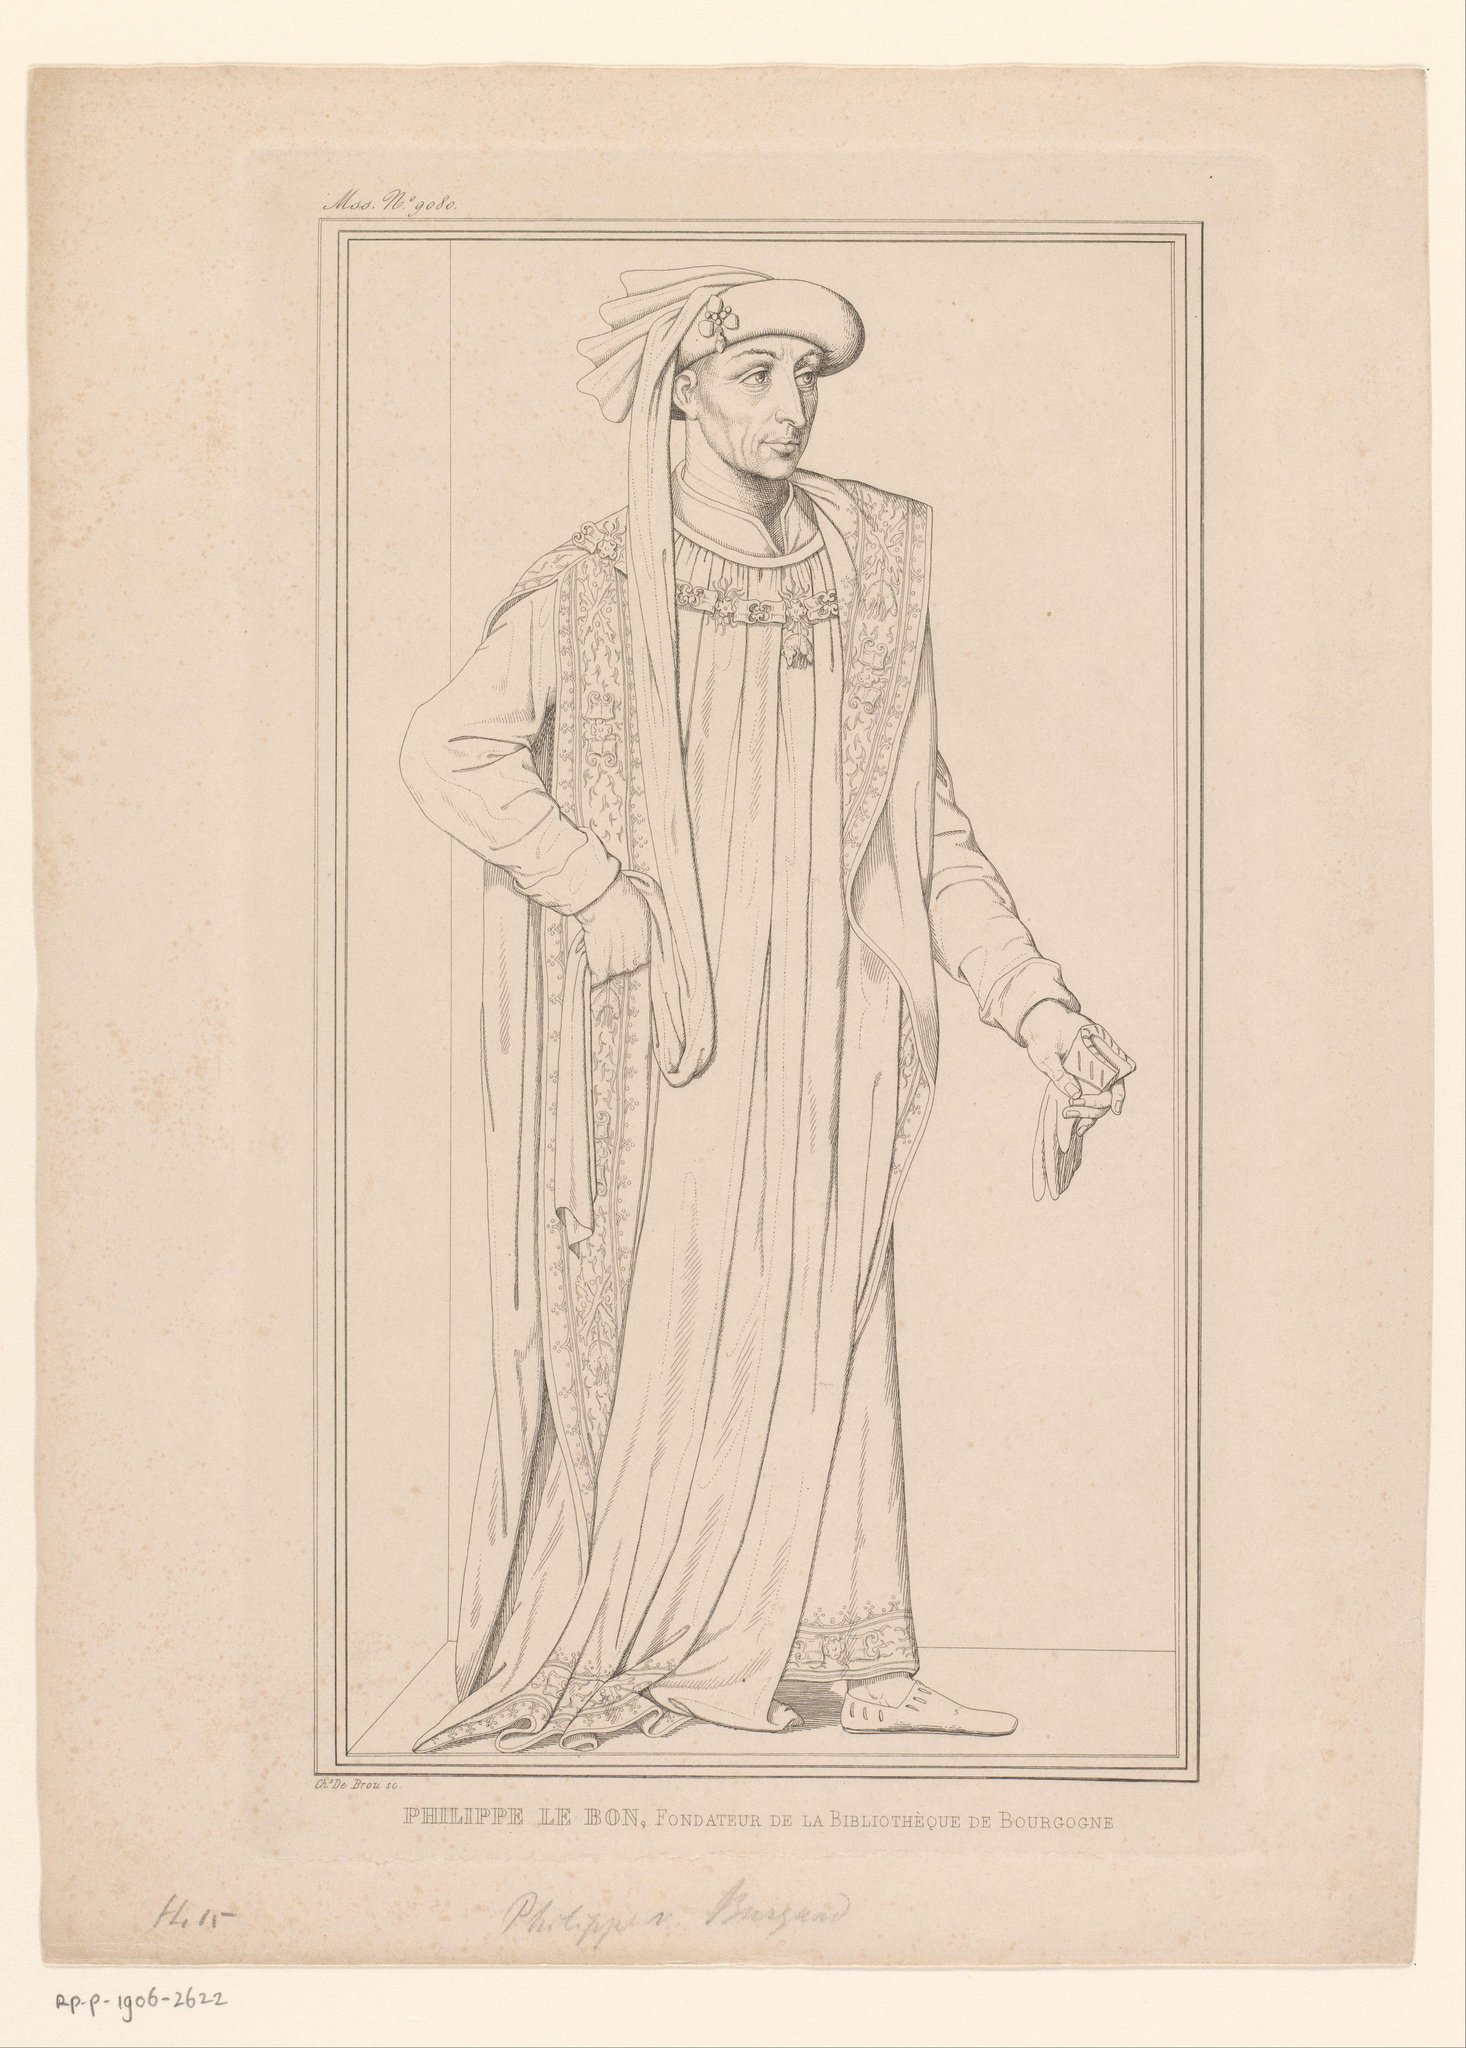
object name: print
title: Filips de Goede van Bourgondië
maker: charles de brou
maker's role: print maker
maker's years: 1811-1877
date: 1821-1877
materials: paper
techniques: etching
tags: philip iii the good, historical persons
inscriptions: collector's mark: Lugt 2228